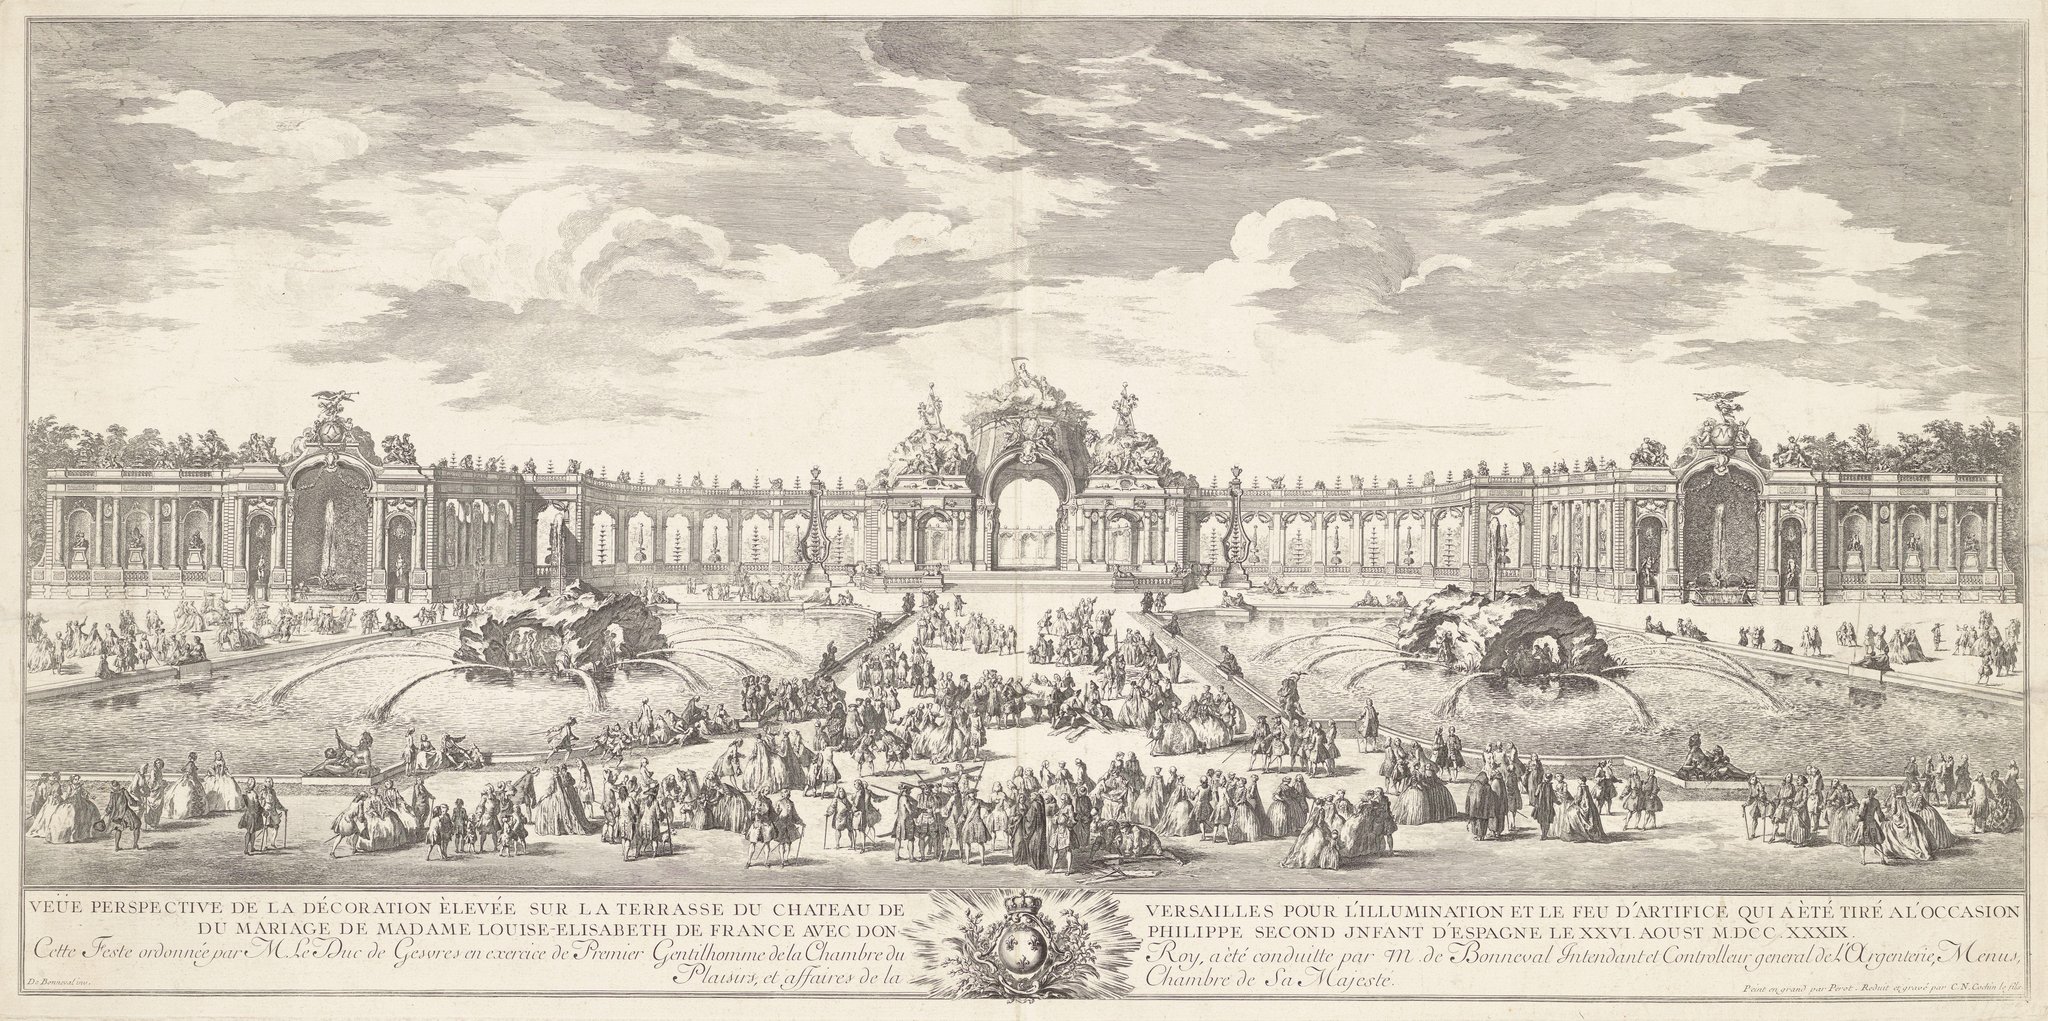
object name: print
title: Zicht op de tuin van Versailles met verlichting en vuurwerk ter gelegenheid van het huwelijk tussen Filips van Spanje en Louise Elisabeth van Frankrijk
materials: paper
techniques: engraving, etching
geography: france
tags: wedding feast, wedding meal, bonfire, fire-works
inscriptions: collector's mark: Lugt 2228, collector's mark: Lugt 451a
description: Met vierregelig onderschrift in het Frans.